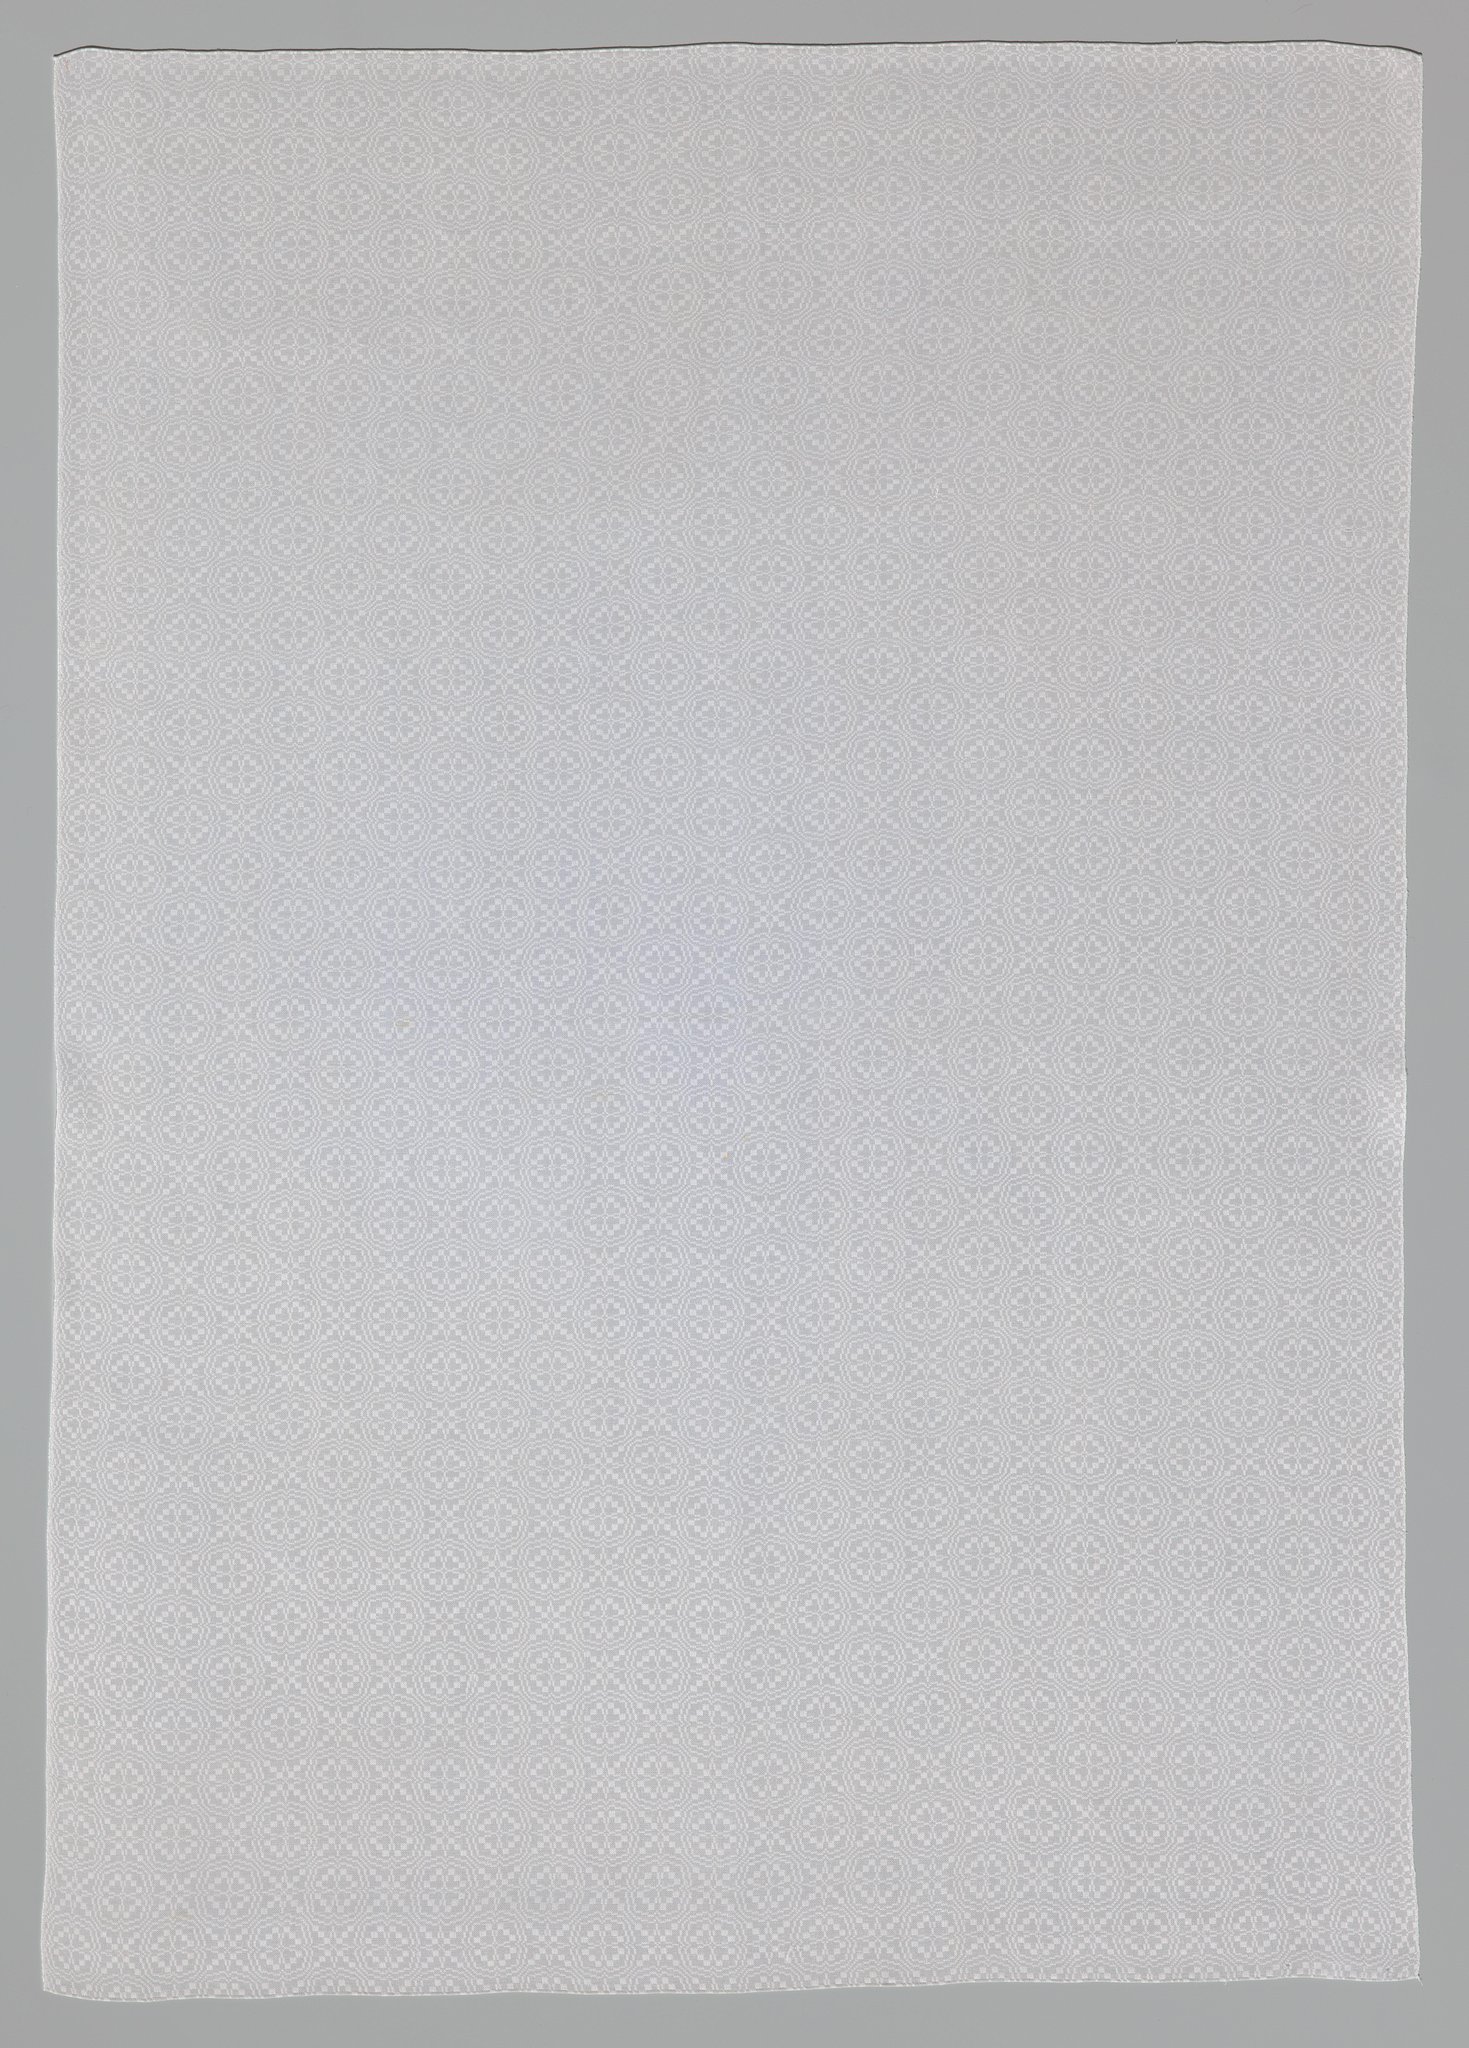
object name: napkin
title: Servet van wit linnen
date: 1640-1670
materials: linen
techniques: peeled fabric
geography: northern netherlands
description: Wit linnen servet. Pellen keper. Merk TC en 22.